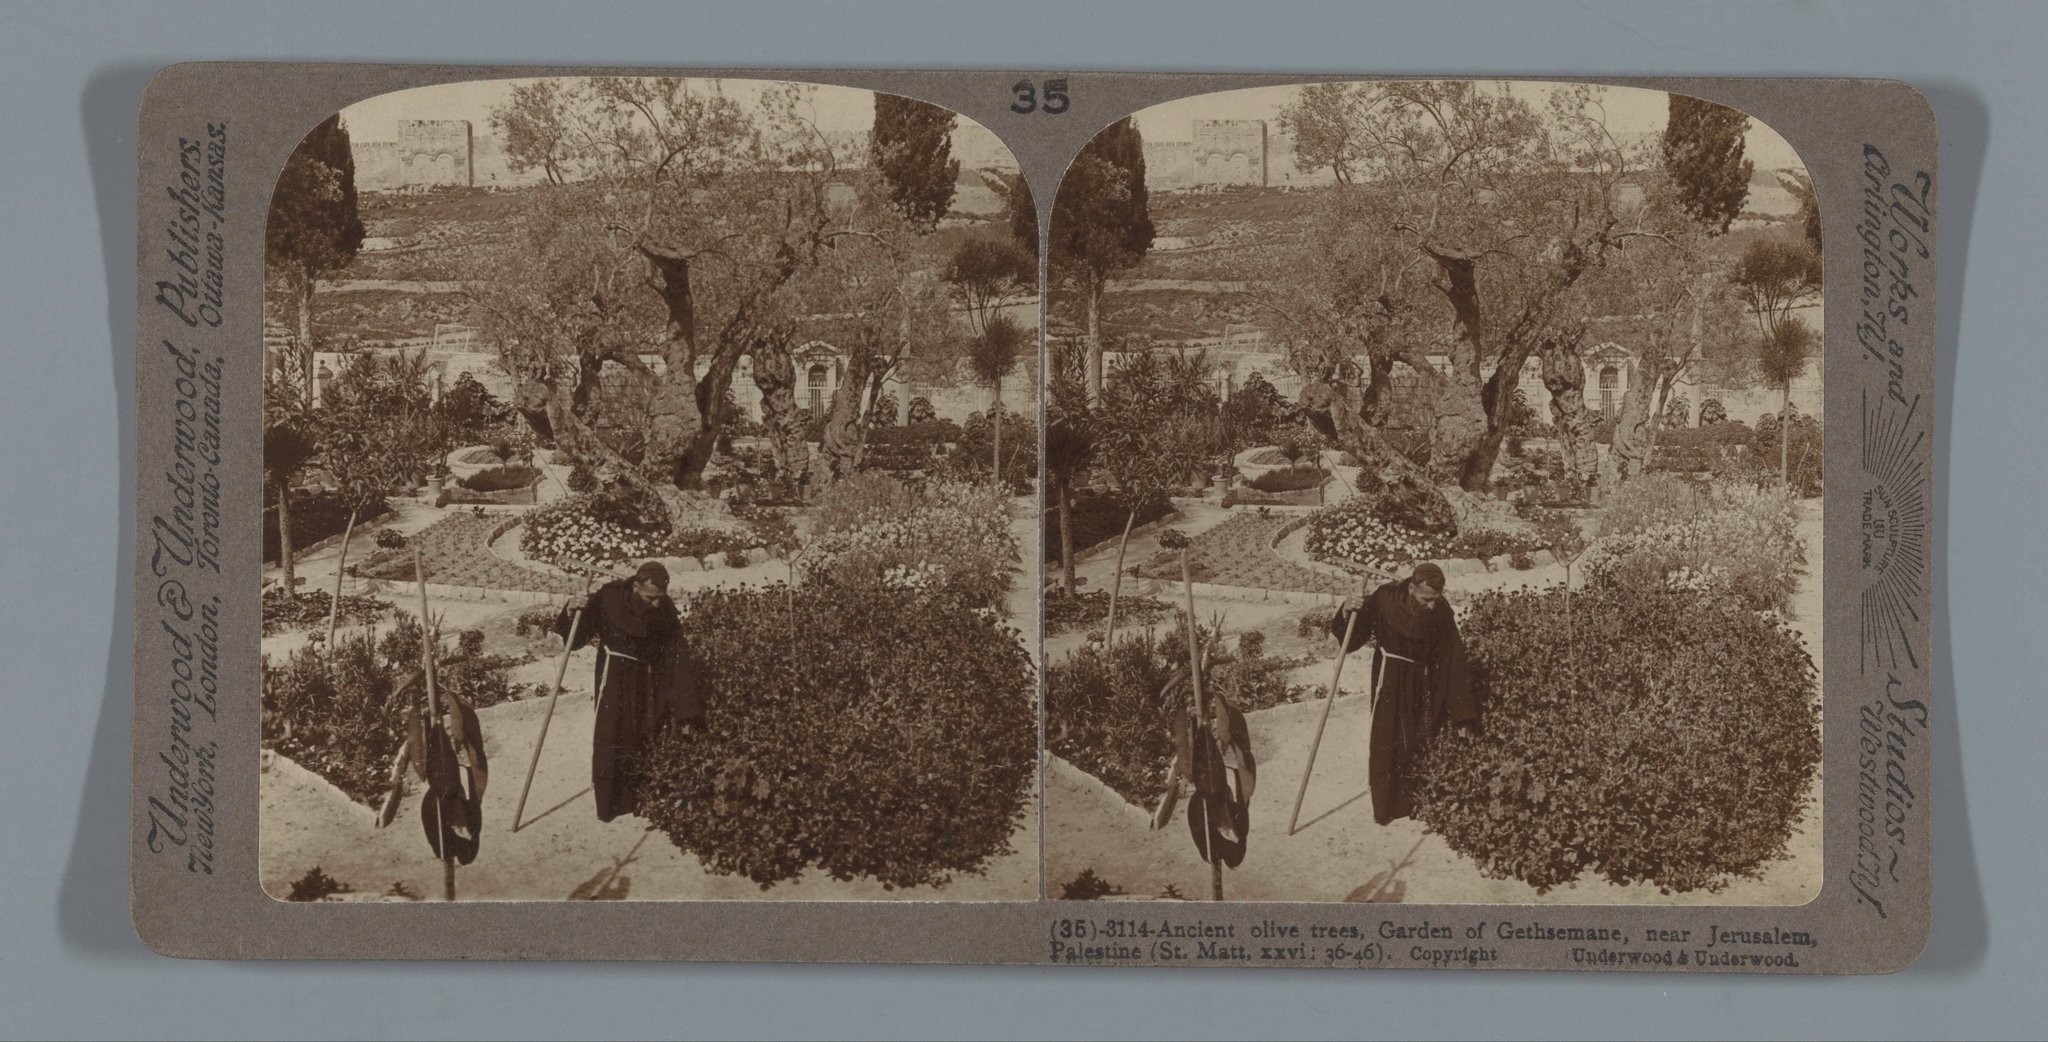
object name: stereograph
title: Ancient olive trees, Garden of Gethsemane, near Jerusalem, Palestine ( St. Matt, xxvi:36-46)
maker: Anonymous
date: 1900-1905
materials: paper, cardboard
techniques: gelatin silver print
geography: new york city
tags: monk(s), friar(s), gardening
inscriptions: number: ‘(35)-3114-’, inscription, copyright notice: ‘Copyright Underwood & Underwood’, number: ‘35’, inscription: ‘Works and Studios ~/ Arlington, N.J. Westwood, N.J.’